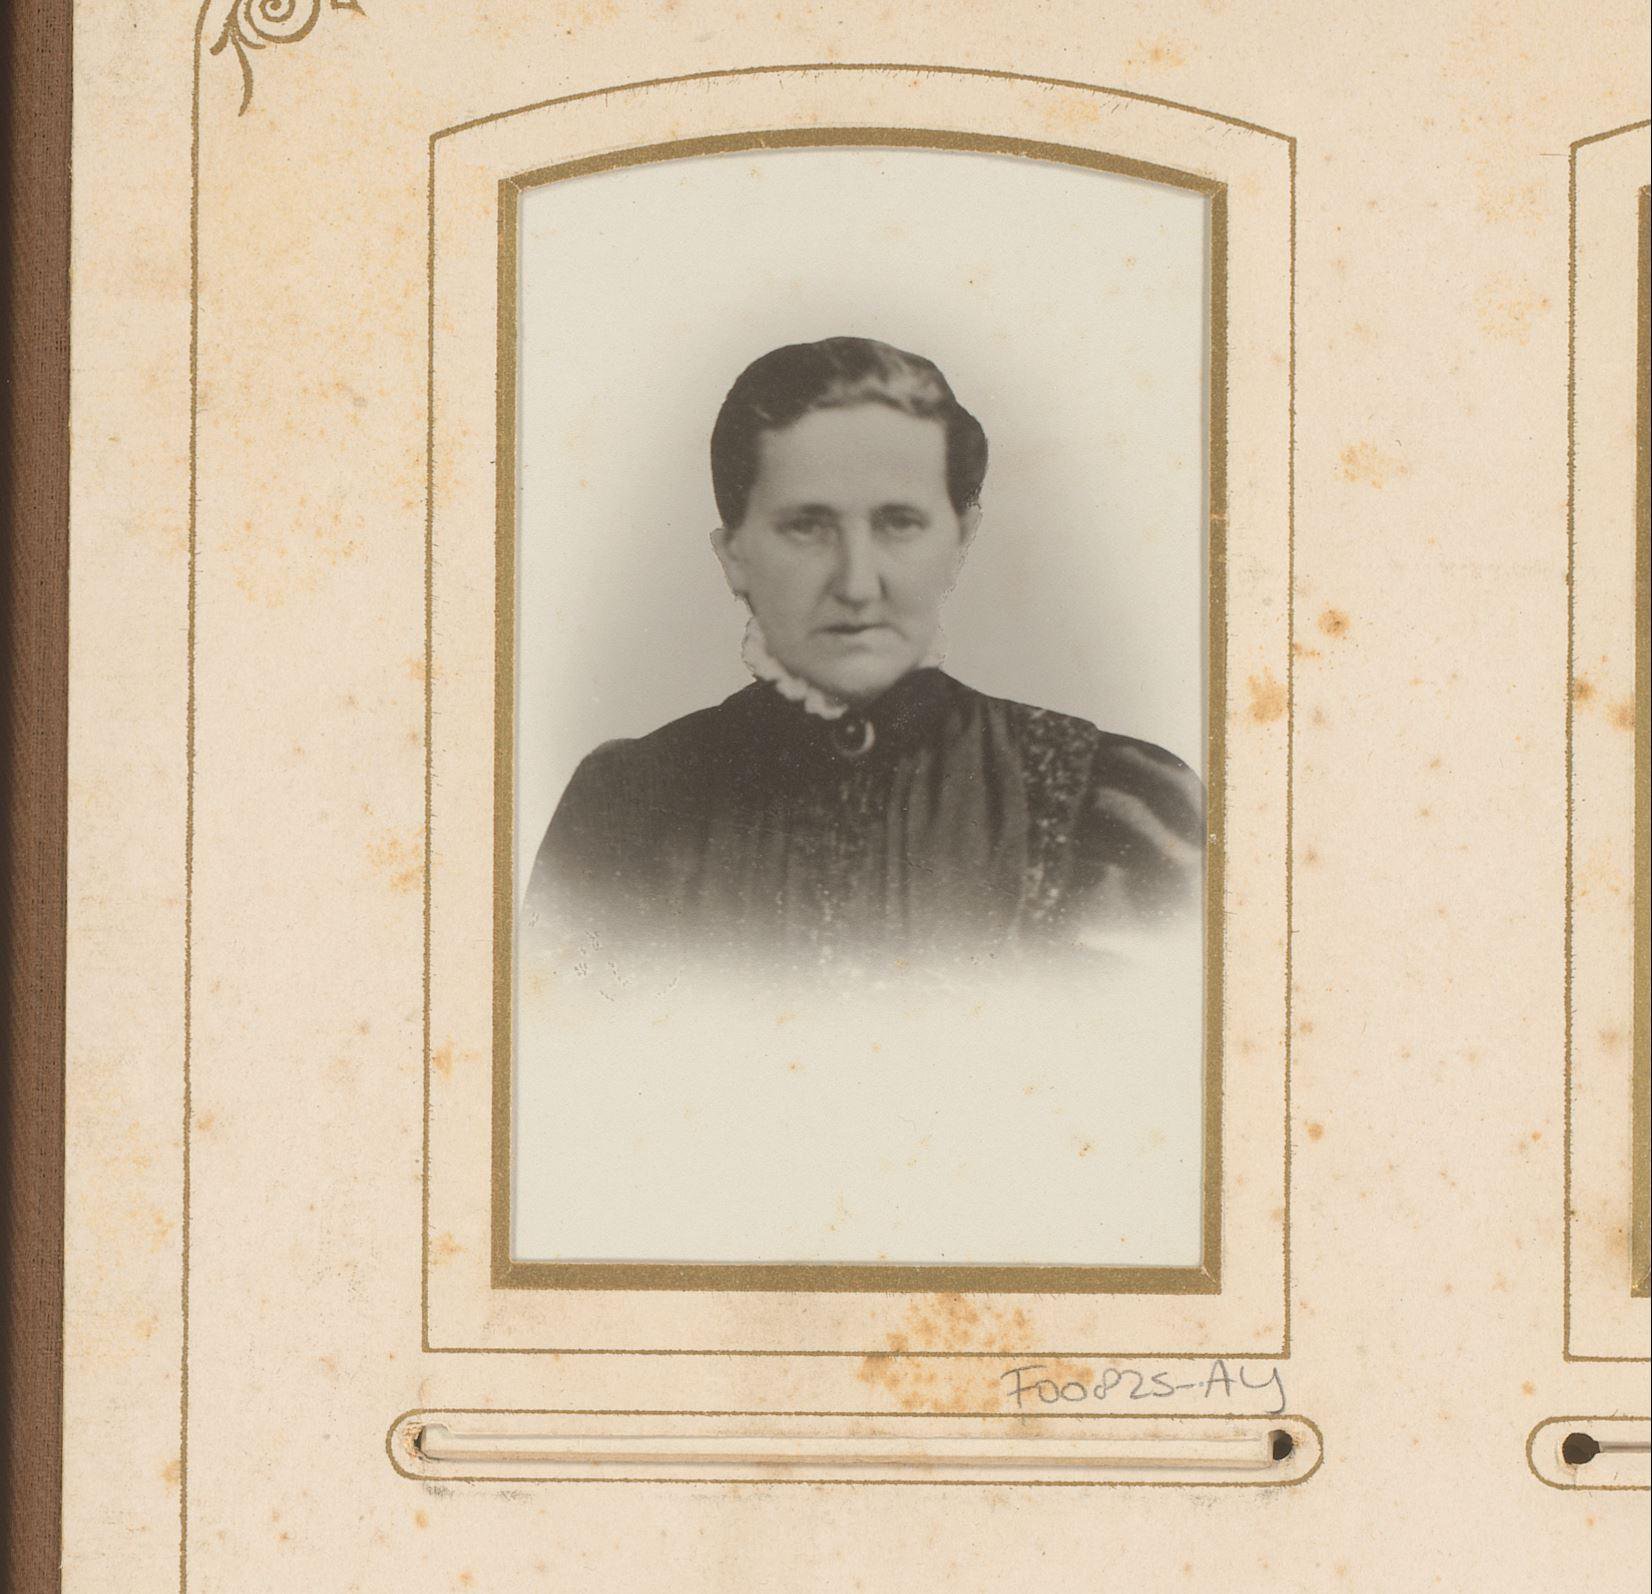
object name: photograph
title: Portret van een vrouw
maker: berend zweers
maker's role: fotograaf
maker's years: 1872-1946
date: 1908-1920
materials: cardboard, photographic support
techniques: matte daylight collodion silver print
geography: haarlem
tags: historical persons - bb - woman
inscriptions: inscription: ‘B. Zweers/ GROOTE HOUTSTRAAT 174/ HAARLEM./ Telefoon 1669/ Onderscheidingen./ Amsterdam 1895 - Turijn 1902/ 's Gravenhage 1906 - Leeuwarden 1906/ Leiden 1907 - Harlingen 1908 - Zeist 1908/ 's Gravenhage 1908 - Amsterdam 1908’